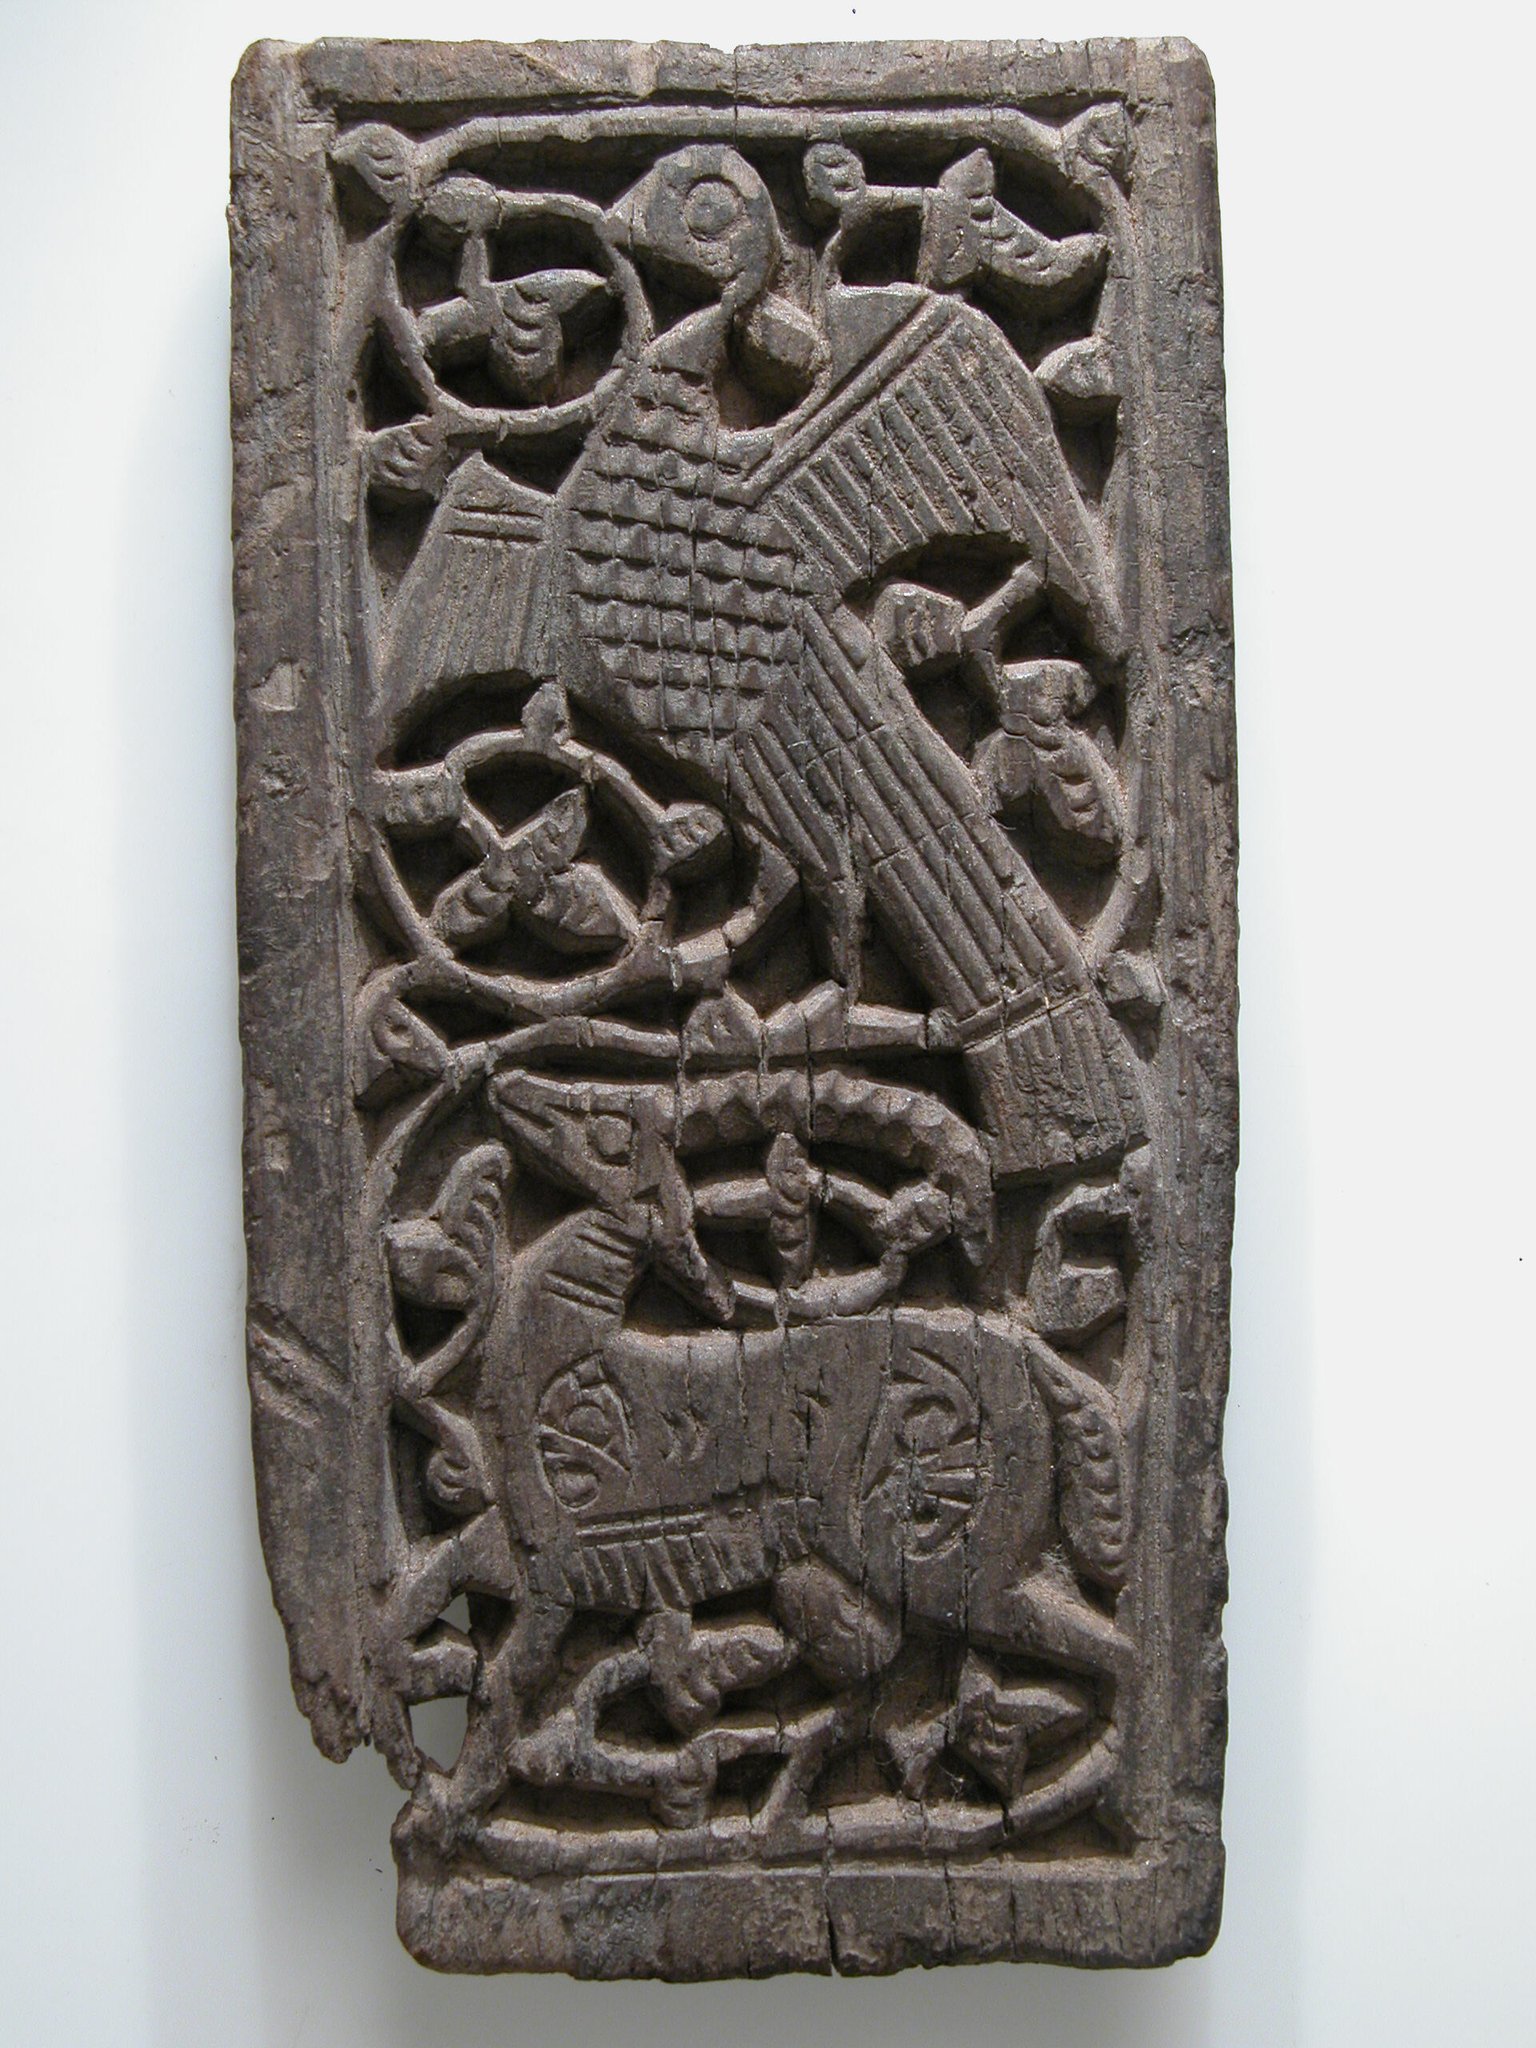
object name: panel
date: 901-1200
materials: wood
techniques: carving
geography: egypt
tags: animals,birds